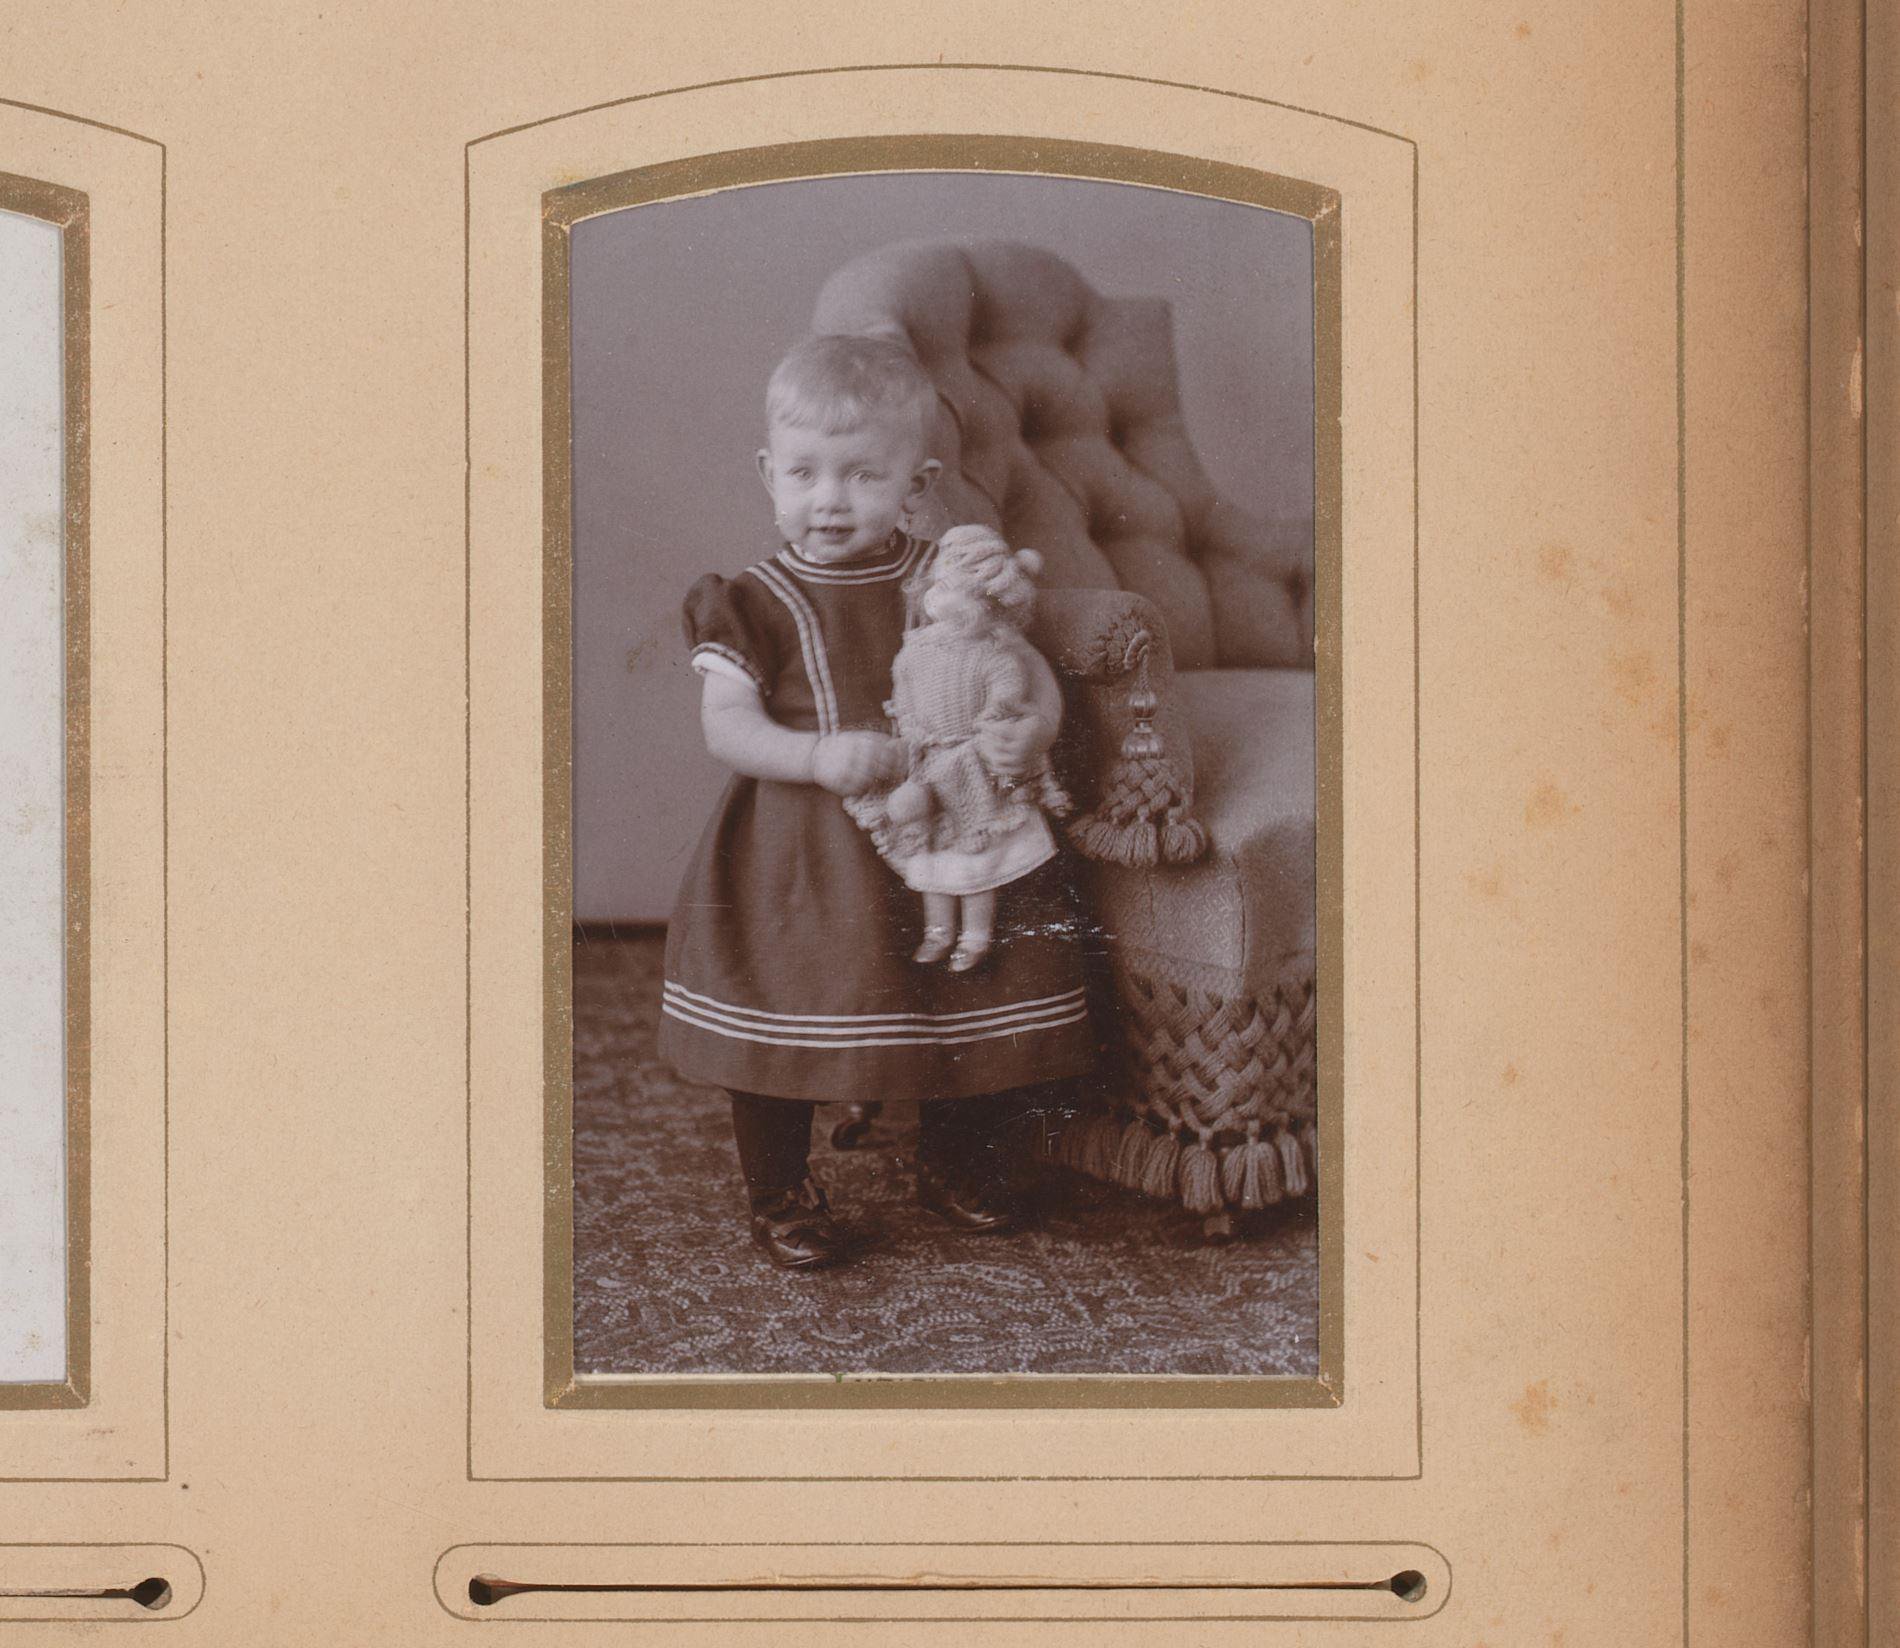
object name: carte de visite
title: Portret van een staand kind met pop in de hand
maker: johannes georg jacobus van arum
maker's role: fotograaf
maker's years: 1843-1917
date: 1880-1917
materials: cardboard, photographic support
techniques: collodion silver print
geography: amsterdam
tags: historical persons, (playing with) dolls, tot, toddler ~ the ages of man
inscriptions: inscription: ‘Photographische Inrichting ,,DAGUERRE"/ van/ J.G.J. van ARUM/ WETERINGSCHANS III/ AMSTERDAM’